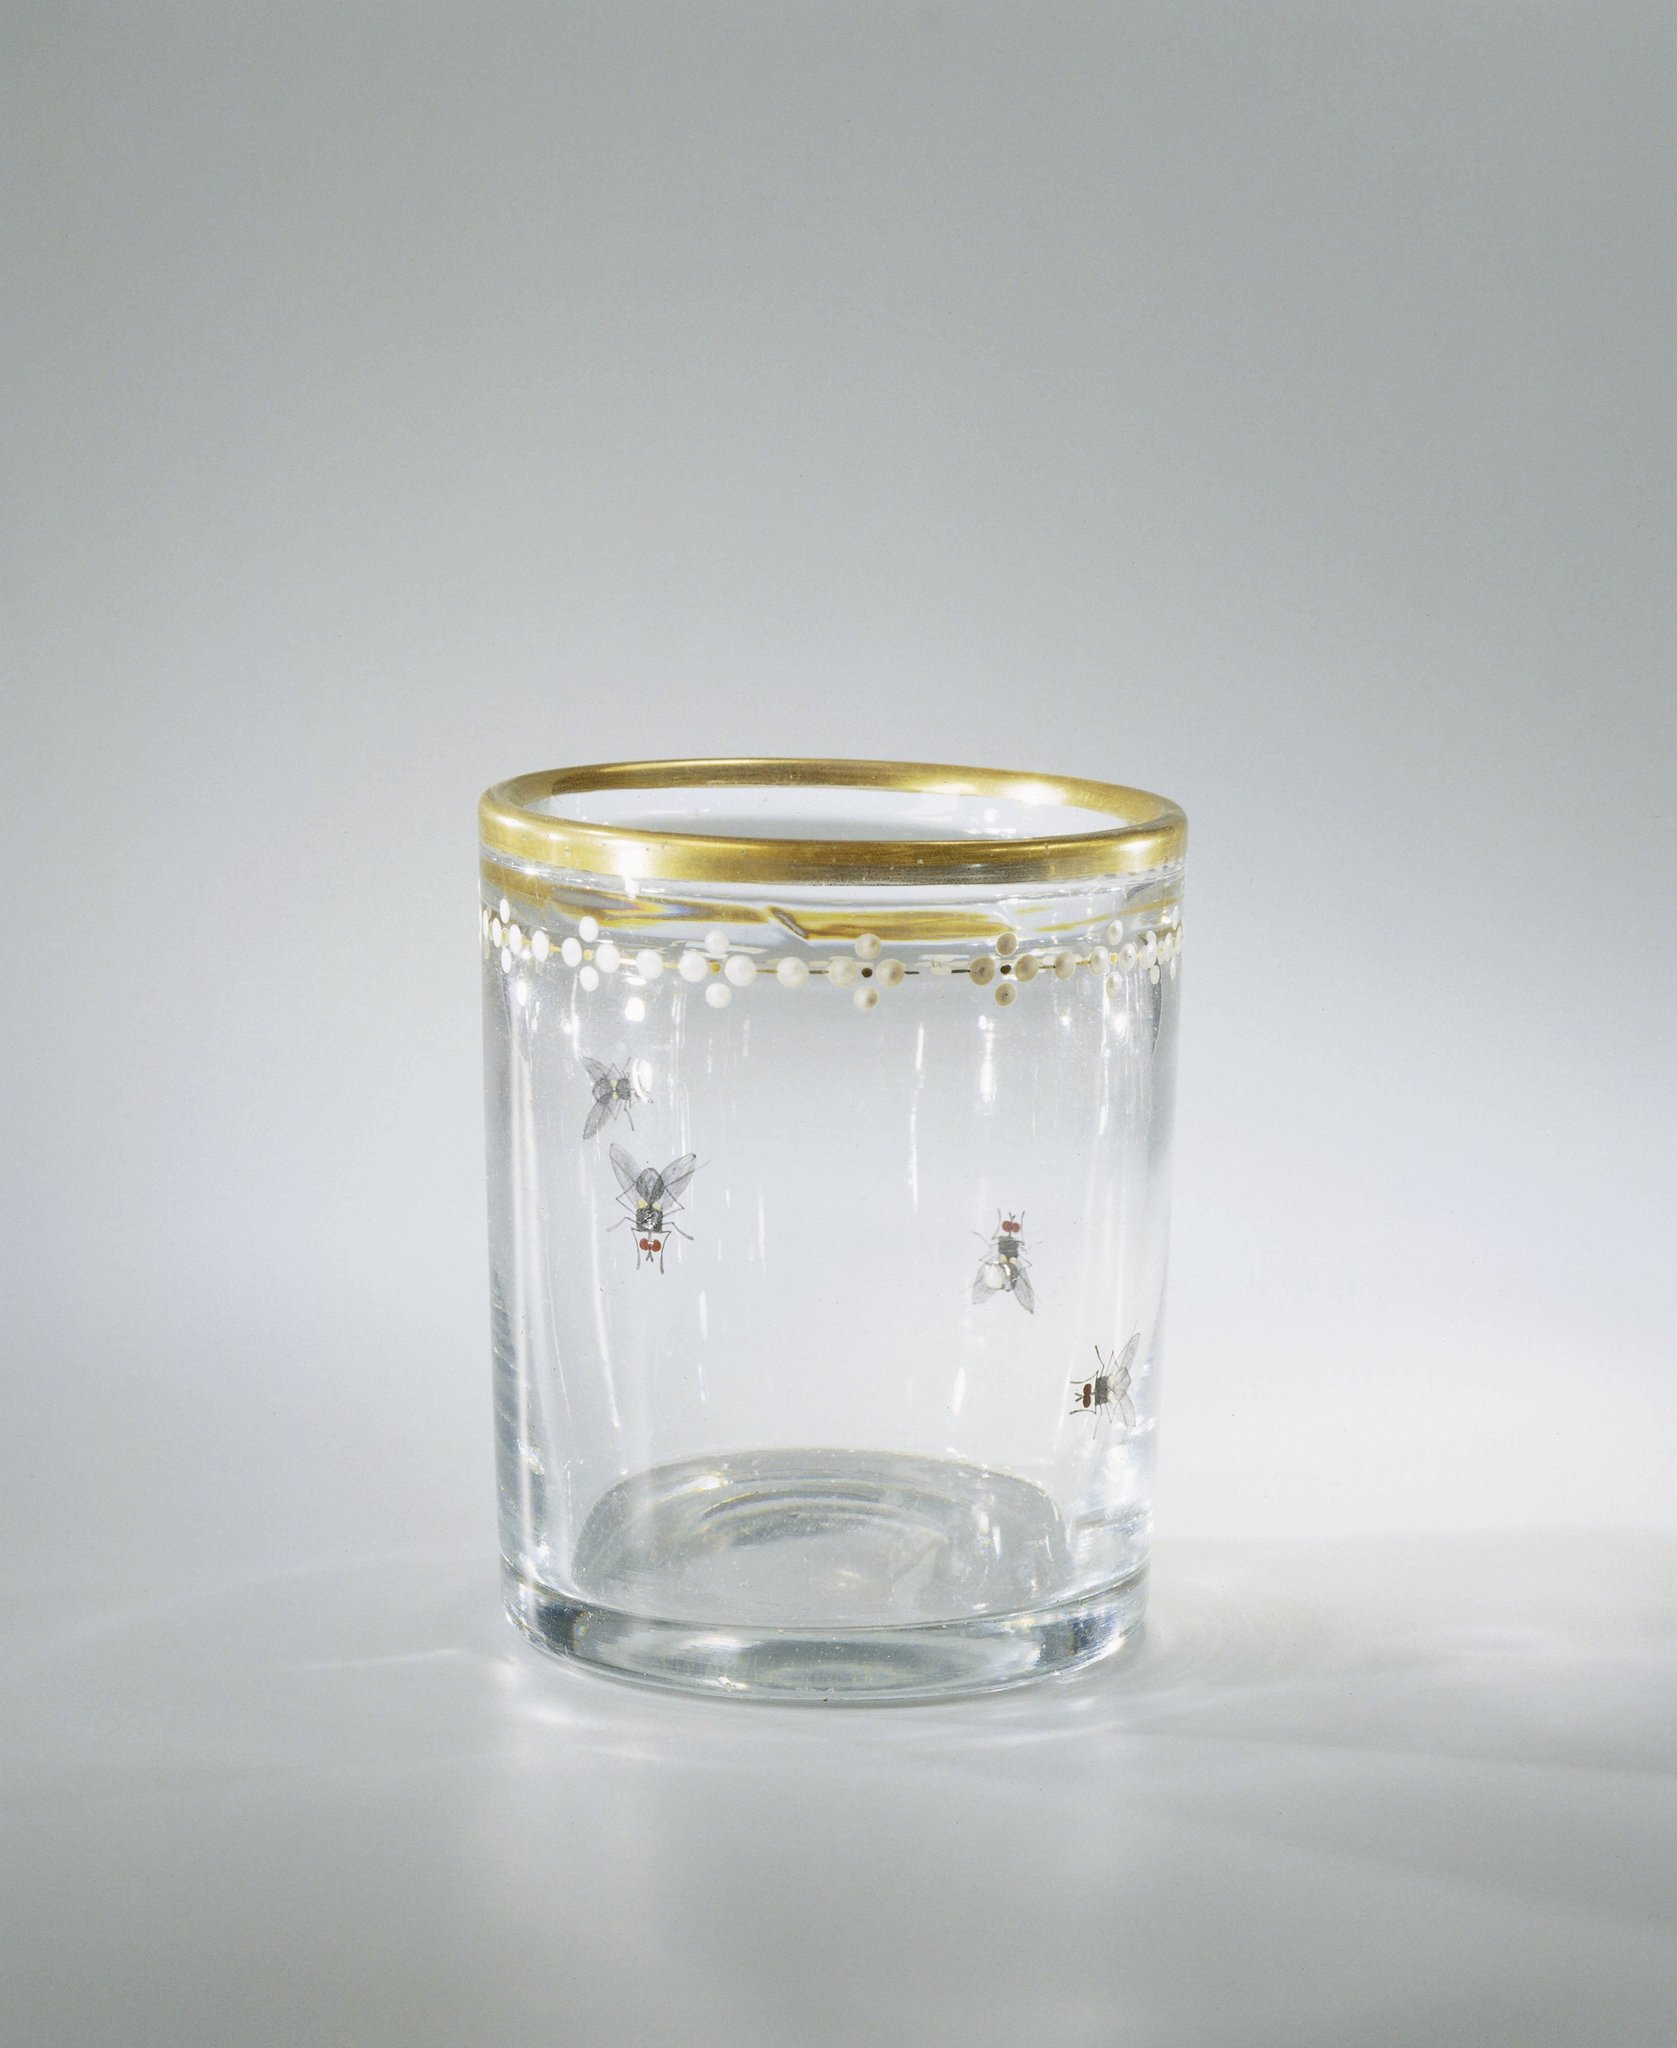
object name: cup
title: Beker met vier vliegen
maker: anton kothgasser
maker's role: porseleinschilder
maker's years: 1769-1851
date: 1815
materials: glass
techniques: gilding, glassblowing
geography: vienna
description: Vlakke bodem. Cylindervormig lichaam, beschilderd met vier vliegen. Onder de vergulde bovenrand een band van witte rozetten en stippen.